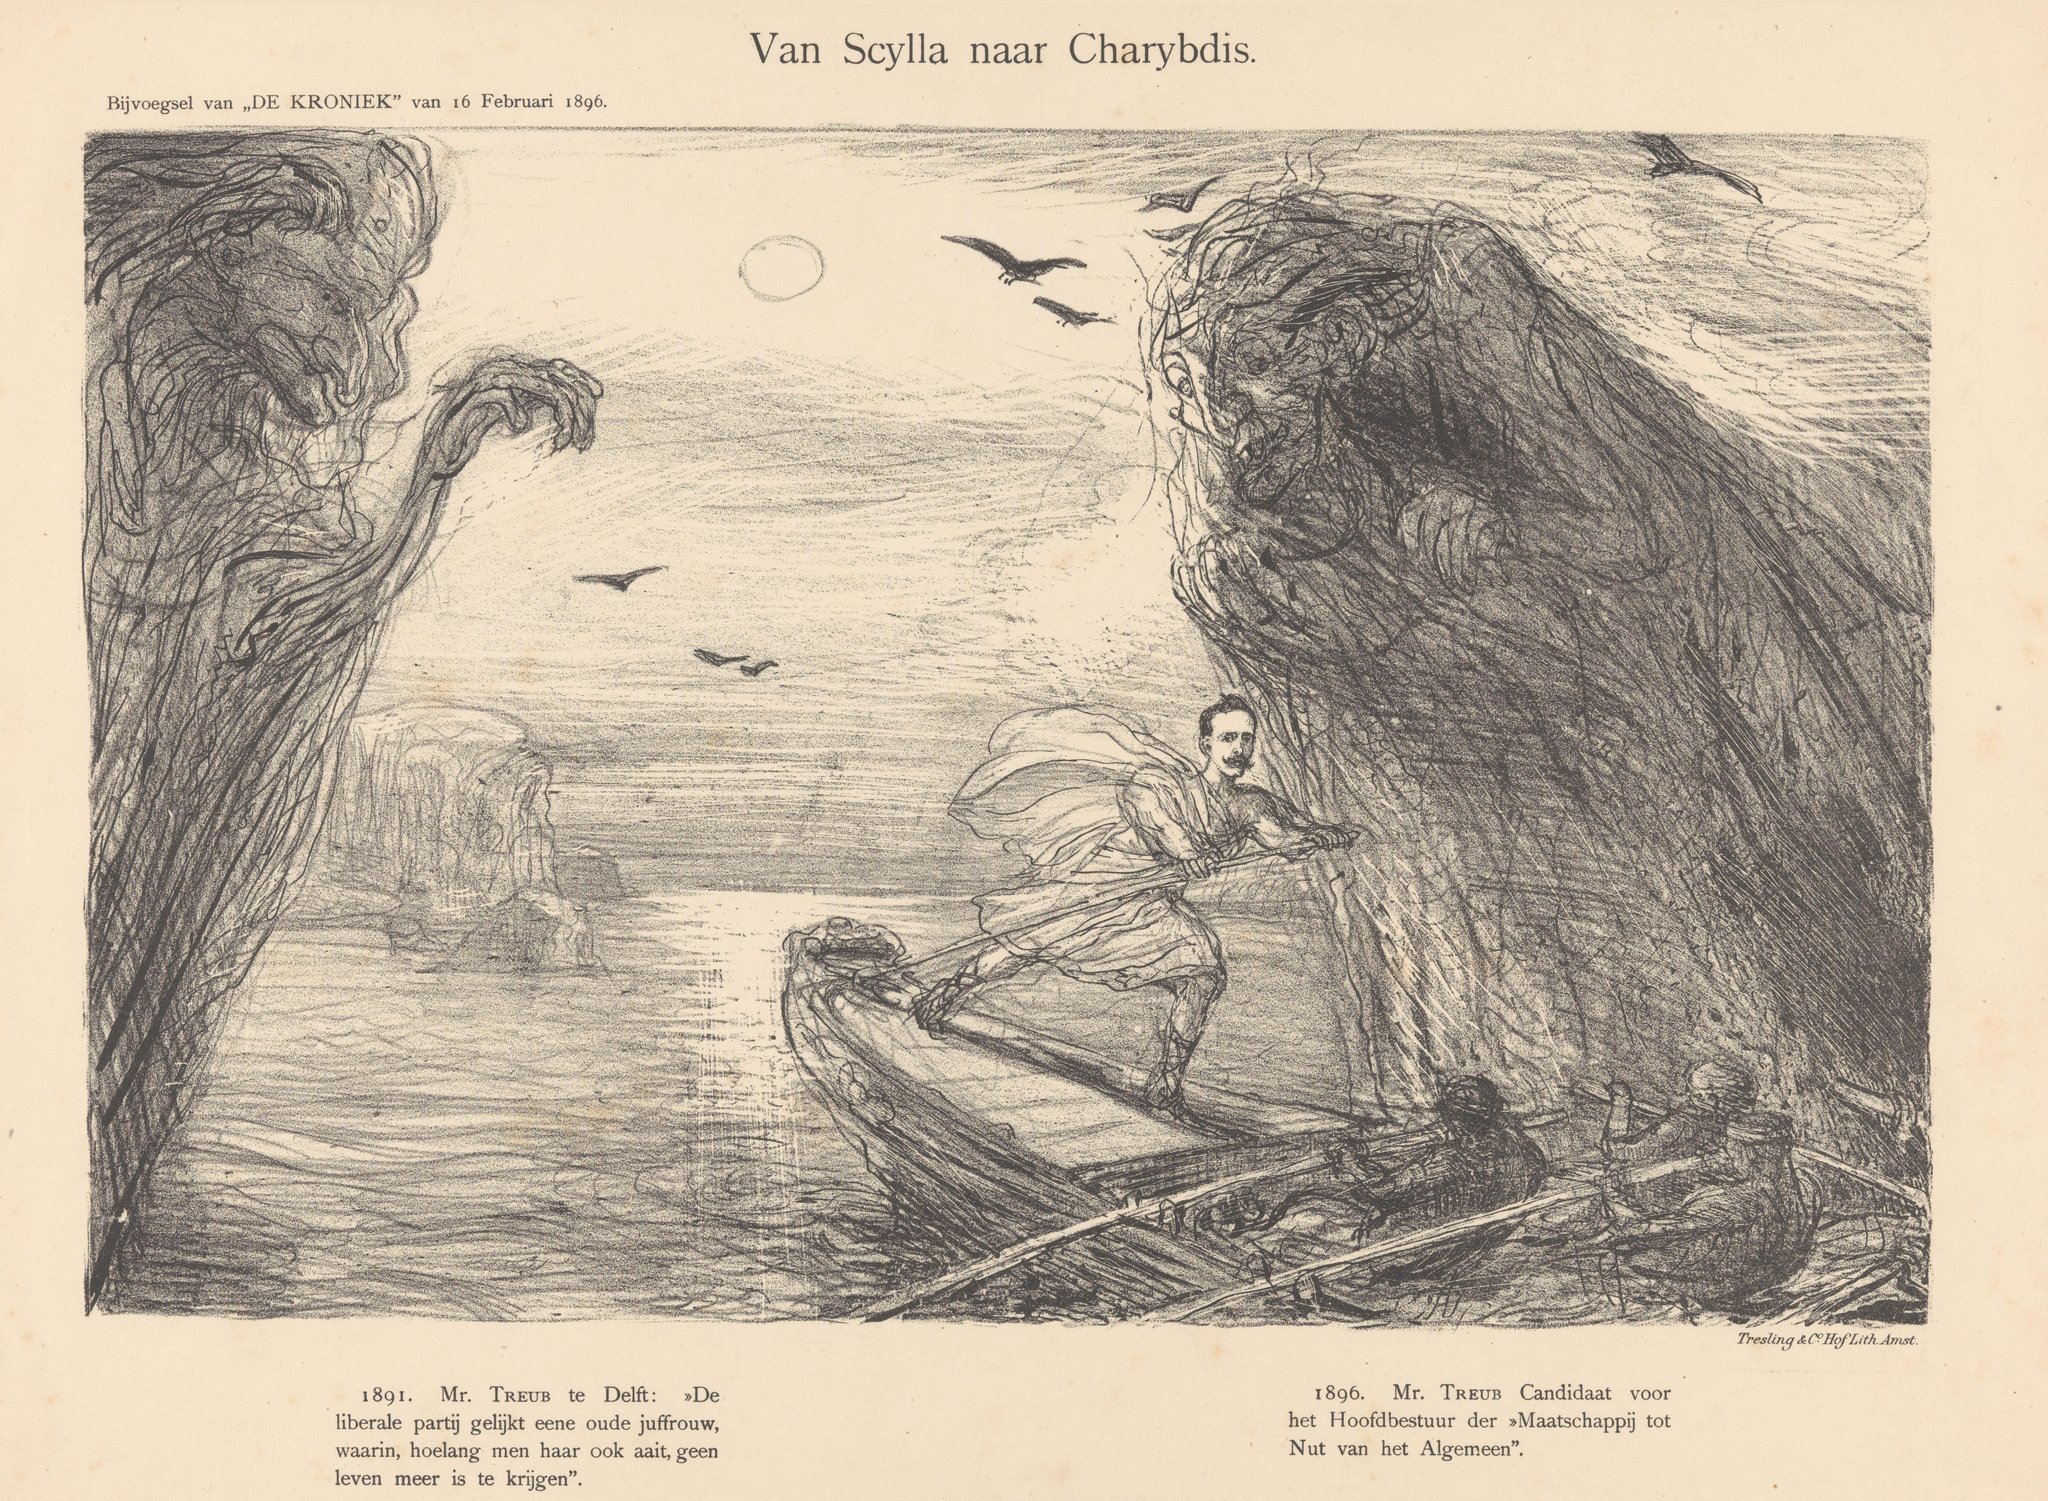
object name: cartoon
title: Willem Treub als Odysseus tussen Scylla en Charybdis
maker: marius bauer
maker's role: draughtsman, print maker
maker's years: 1867-1932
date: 1896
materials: paper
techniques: lithograph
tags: voorschoten, political caricatures and satires, netherlands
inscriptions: collector's mark: Lugt 2228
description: Spotprent op Mr. Treub die zijn schip veilig tussen Scylla en Charybdis door stuurt, een verbeelding van de moeilijke keuze van Treub tussen het wethouderschap en het hoogleraarschap te Amsterdam. In het onderschrift wordt gerefereerd aan zijn kandidatuur voor het hoofdbestuur van de Maatschappij tot Nut van 't Algemeen. Verschenen in het bijvoegsel van 'De Kroniek' van 16 februari 1896.